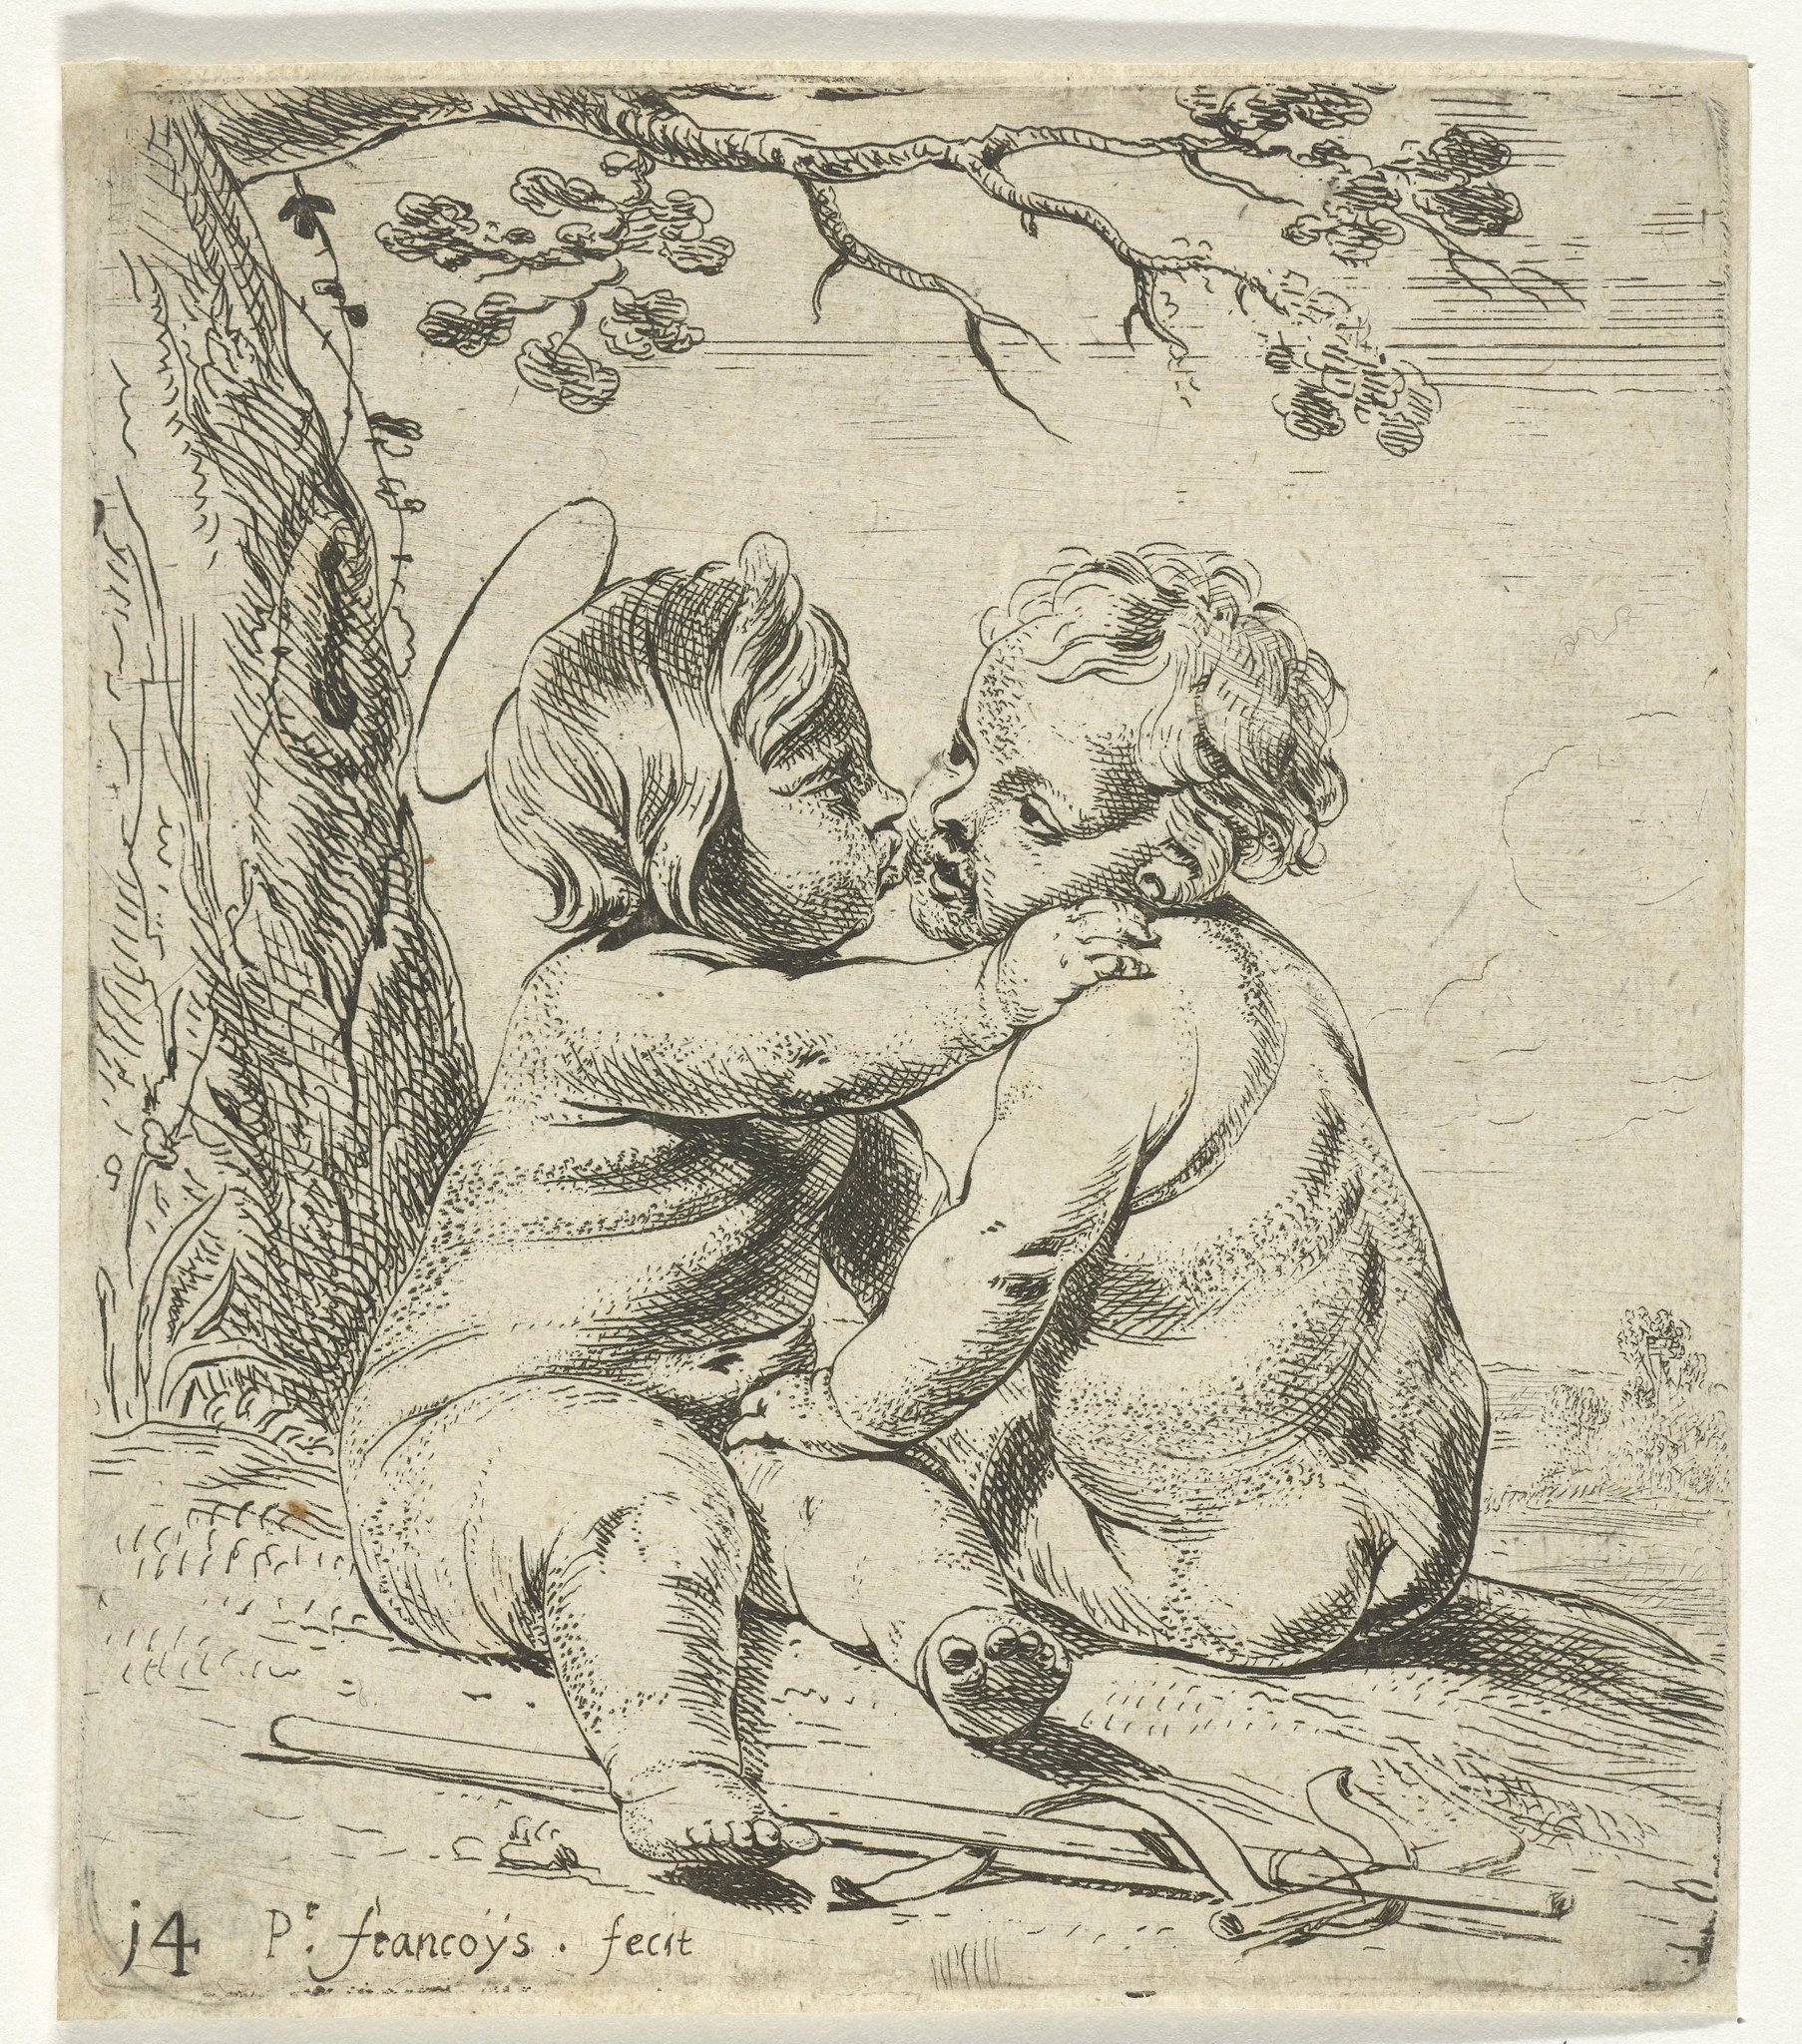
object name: print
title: Christus en Johannes de Doper als kinderen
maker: peter franchoys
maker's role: print maker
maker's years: 1606-1654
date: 1616-1654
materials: paper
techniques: etching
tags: the christ-child and john the baptist (as child)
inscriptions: collector's mark: Lugt 514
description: Christus kust Johannes de Doper op zijn wang, beiden zijn nog kind. Samen zitten ze naakt aan de voet van een boom, op de voorgrond ligt een kruis. Prent linksonder gemerkt: 14.